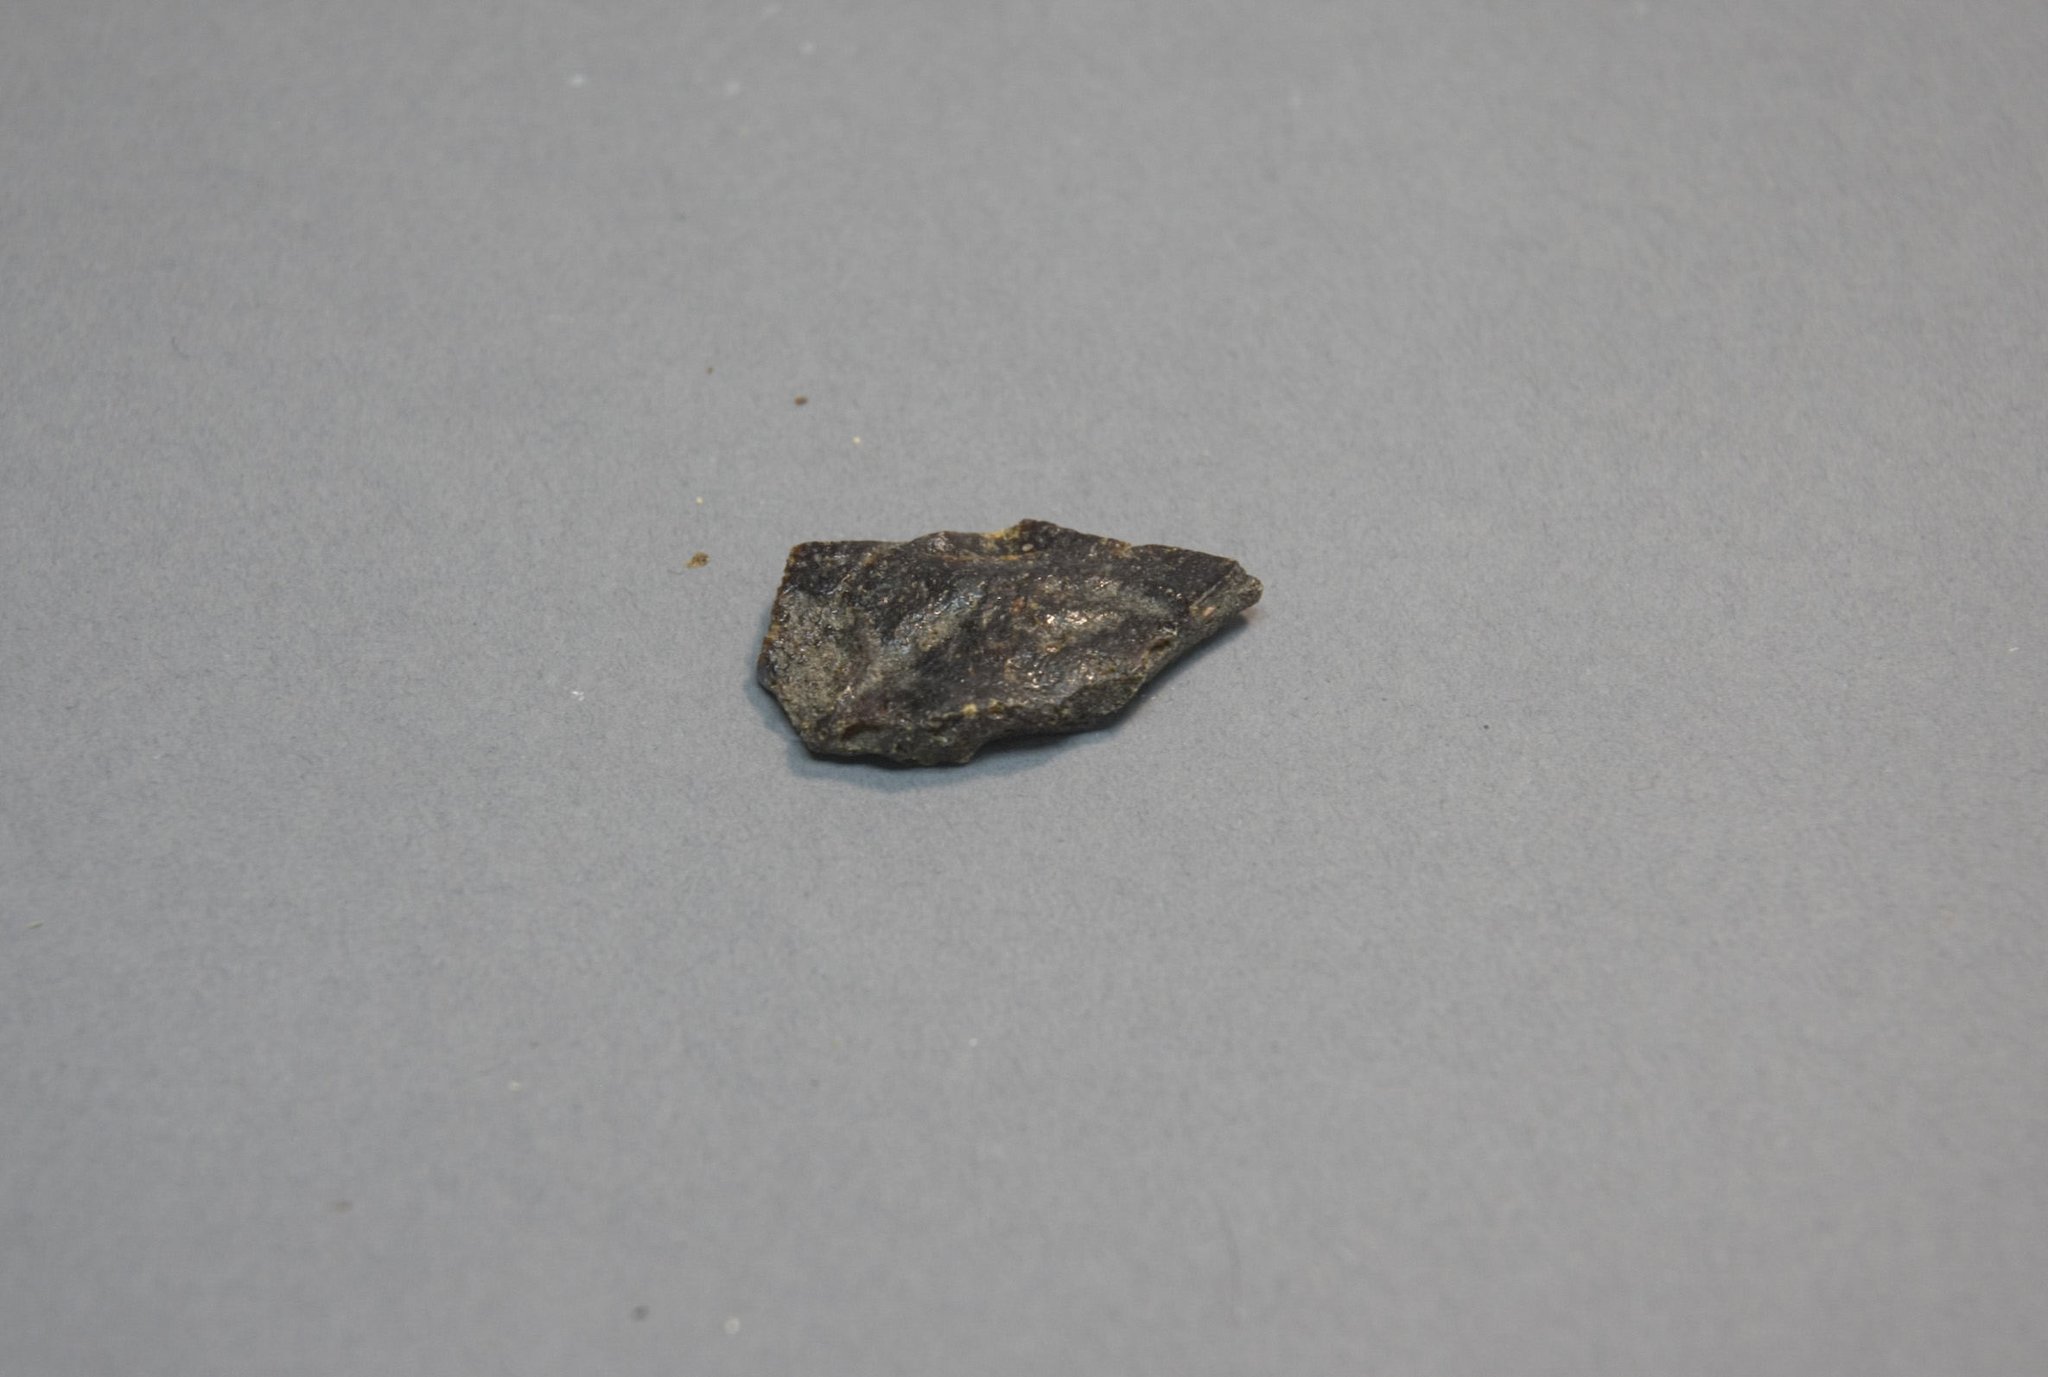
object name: jade carving material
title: Shellac Specimen for Jade Carving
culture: chinese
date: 1901-2000